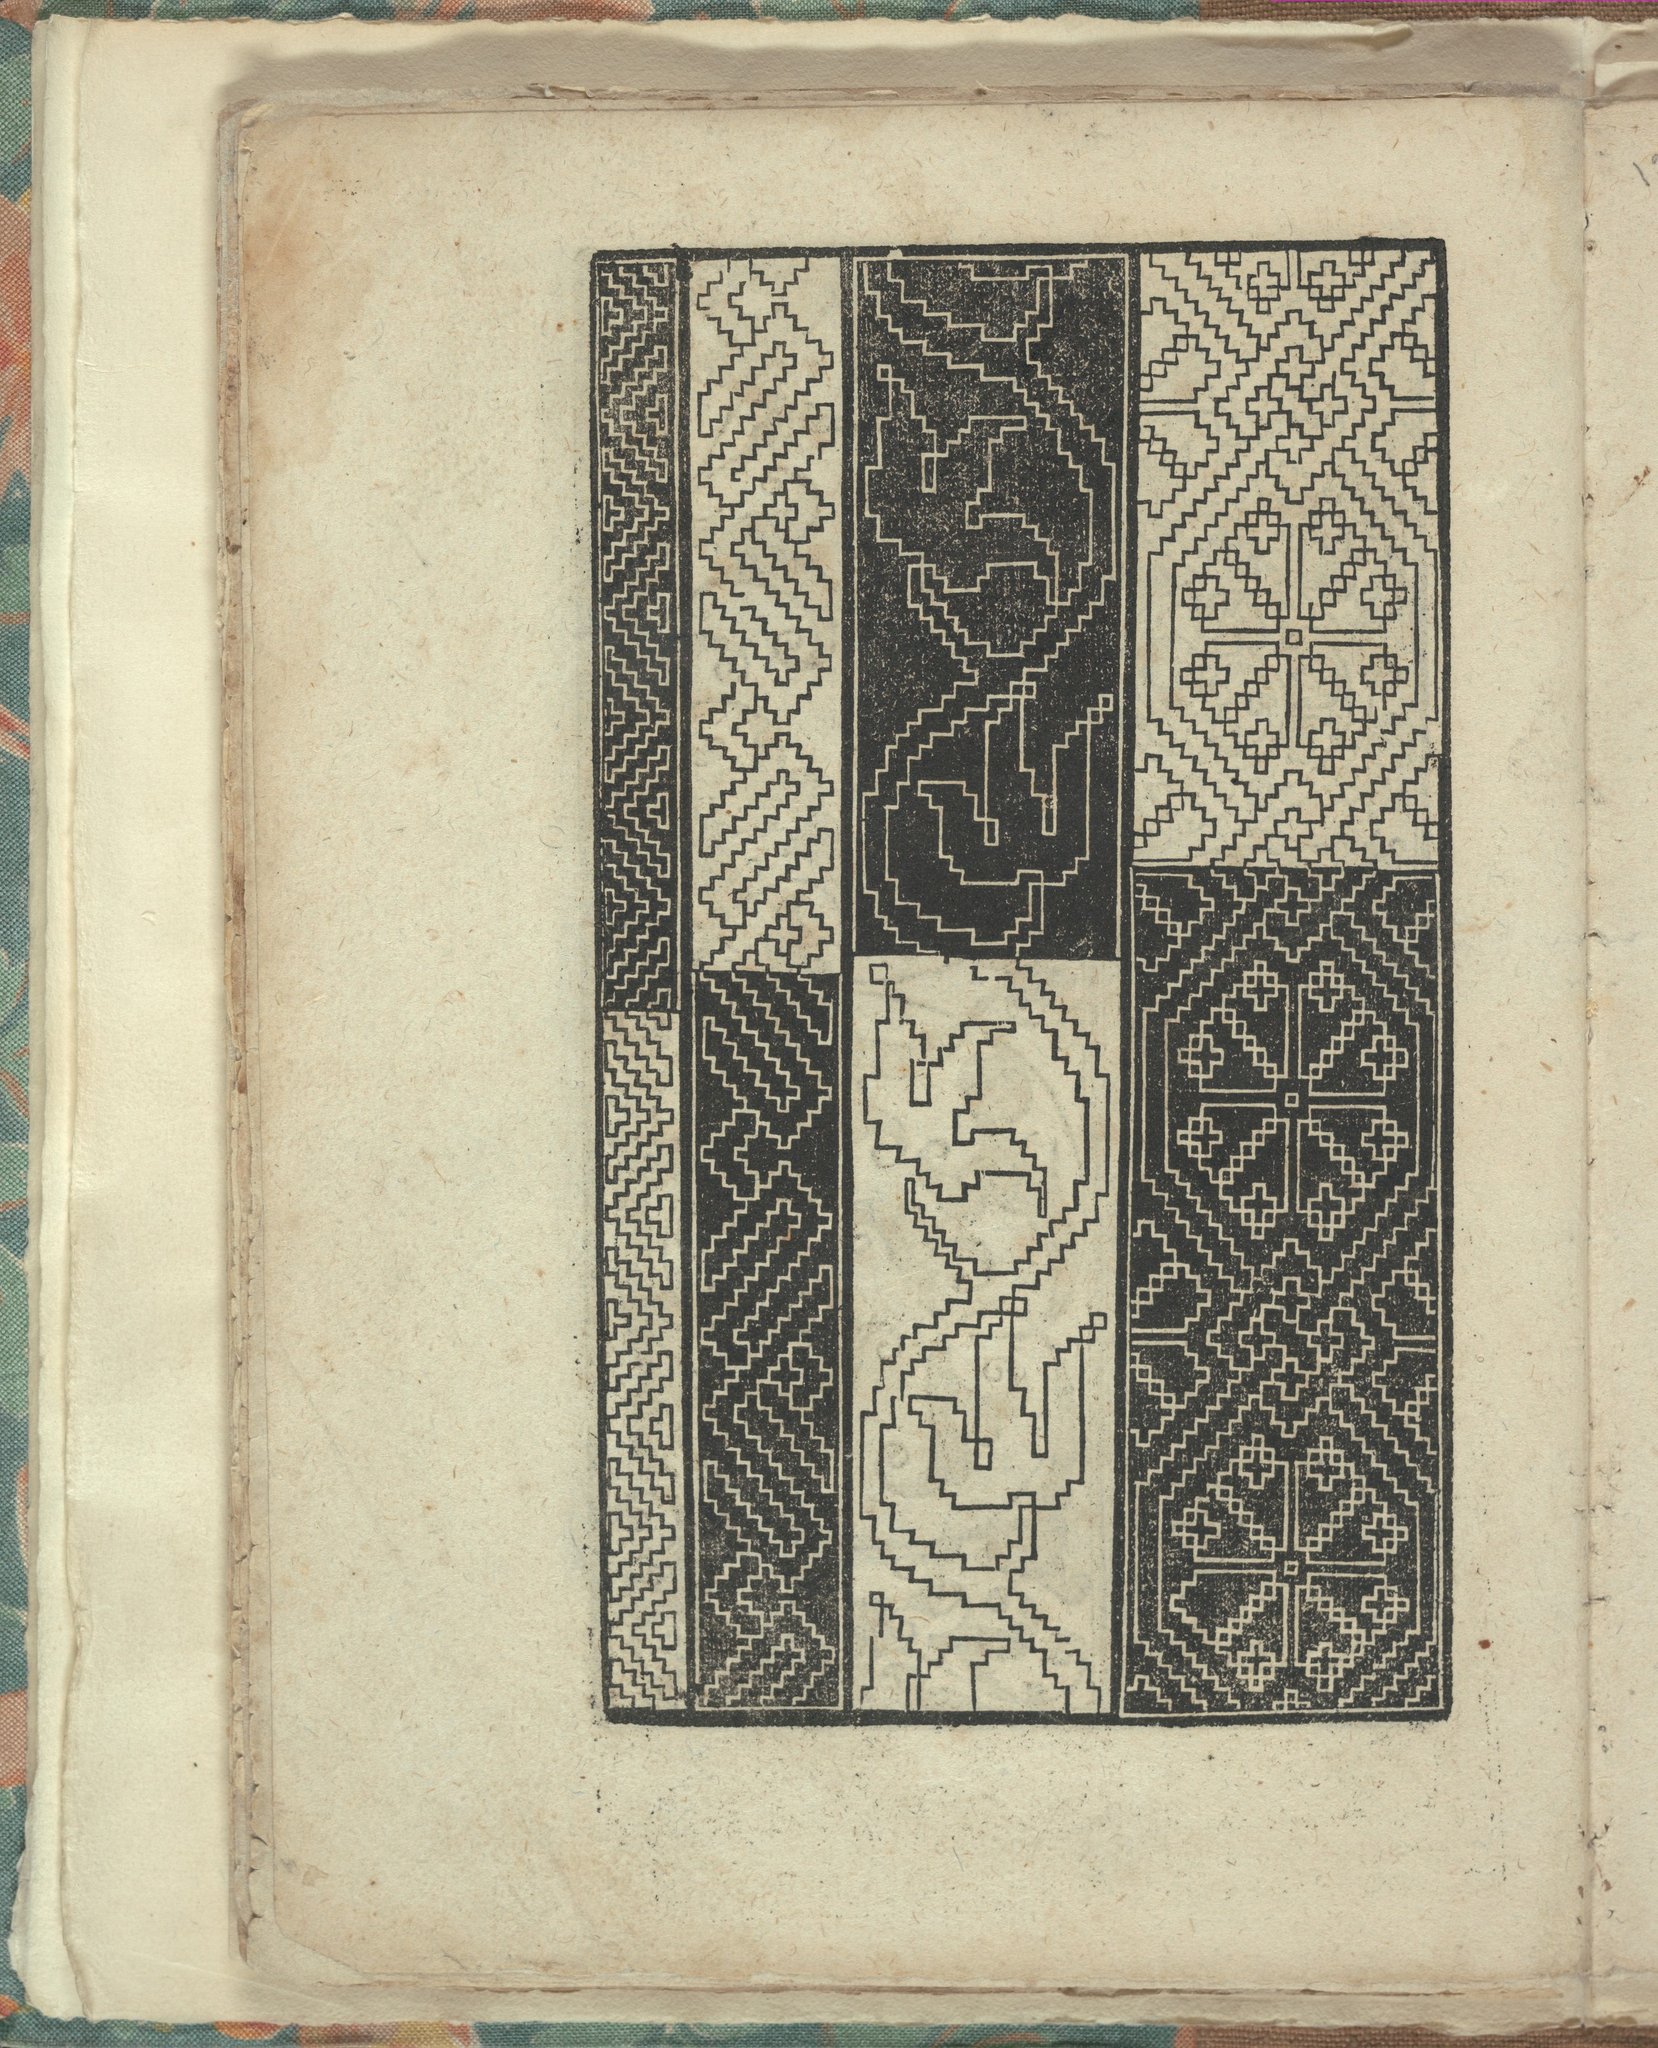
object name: book print ornament architecture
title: Opera Nova Universali intitulata Corona di racammi, page 30 (verso)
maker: giovanni andrea vavassore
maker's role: publisher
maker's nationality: italian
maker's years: 1530-1573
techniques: woodcut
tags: ornament